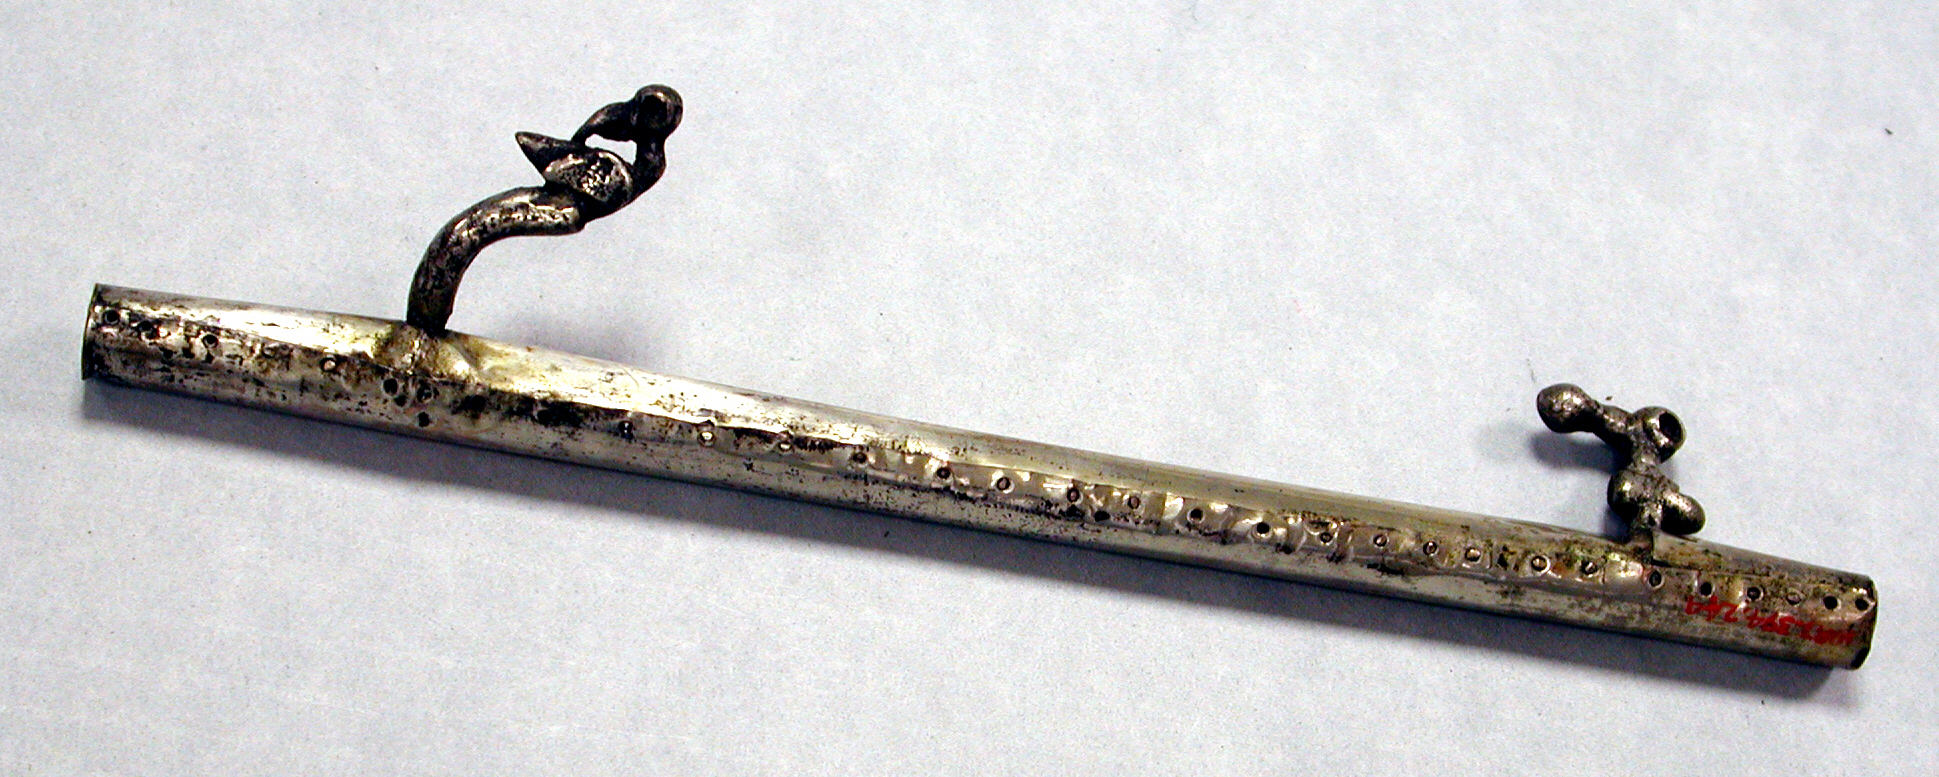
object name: spear thrower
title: Silver Atlatl Spear Thrower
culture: chimú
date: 1101-1500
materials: silver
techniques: casting, hammering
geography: peru